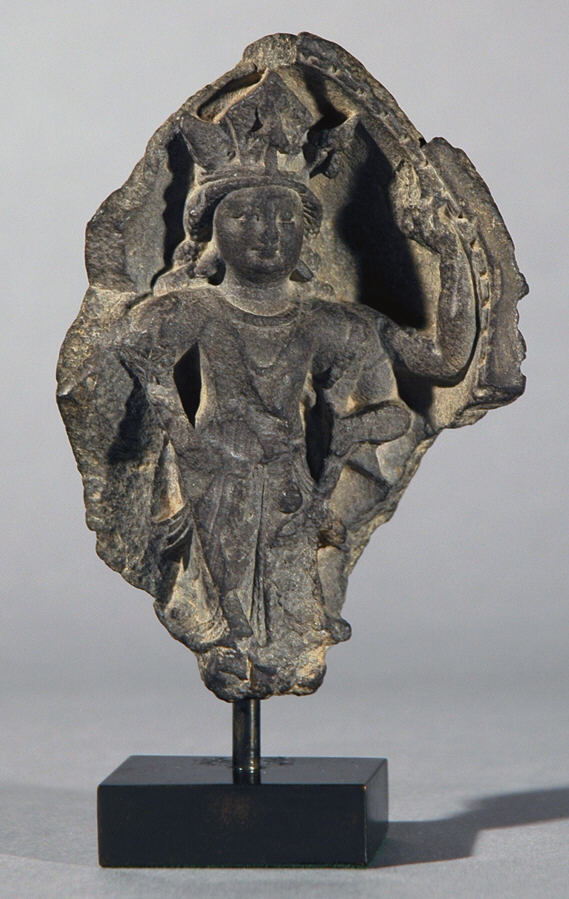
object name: shrine panel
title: Section of a Diptych in Linga Form, Interior Depicting the Face of Shiva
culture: kashmiri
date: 501-700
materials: mineral, stone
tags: kashmir,faces,shiva,hinduism